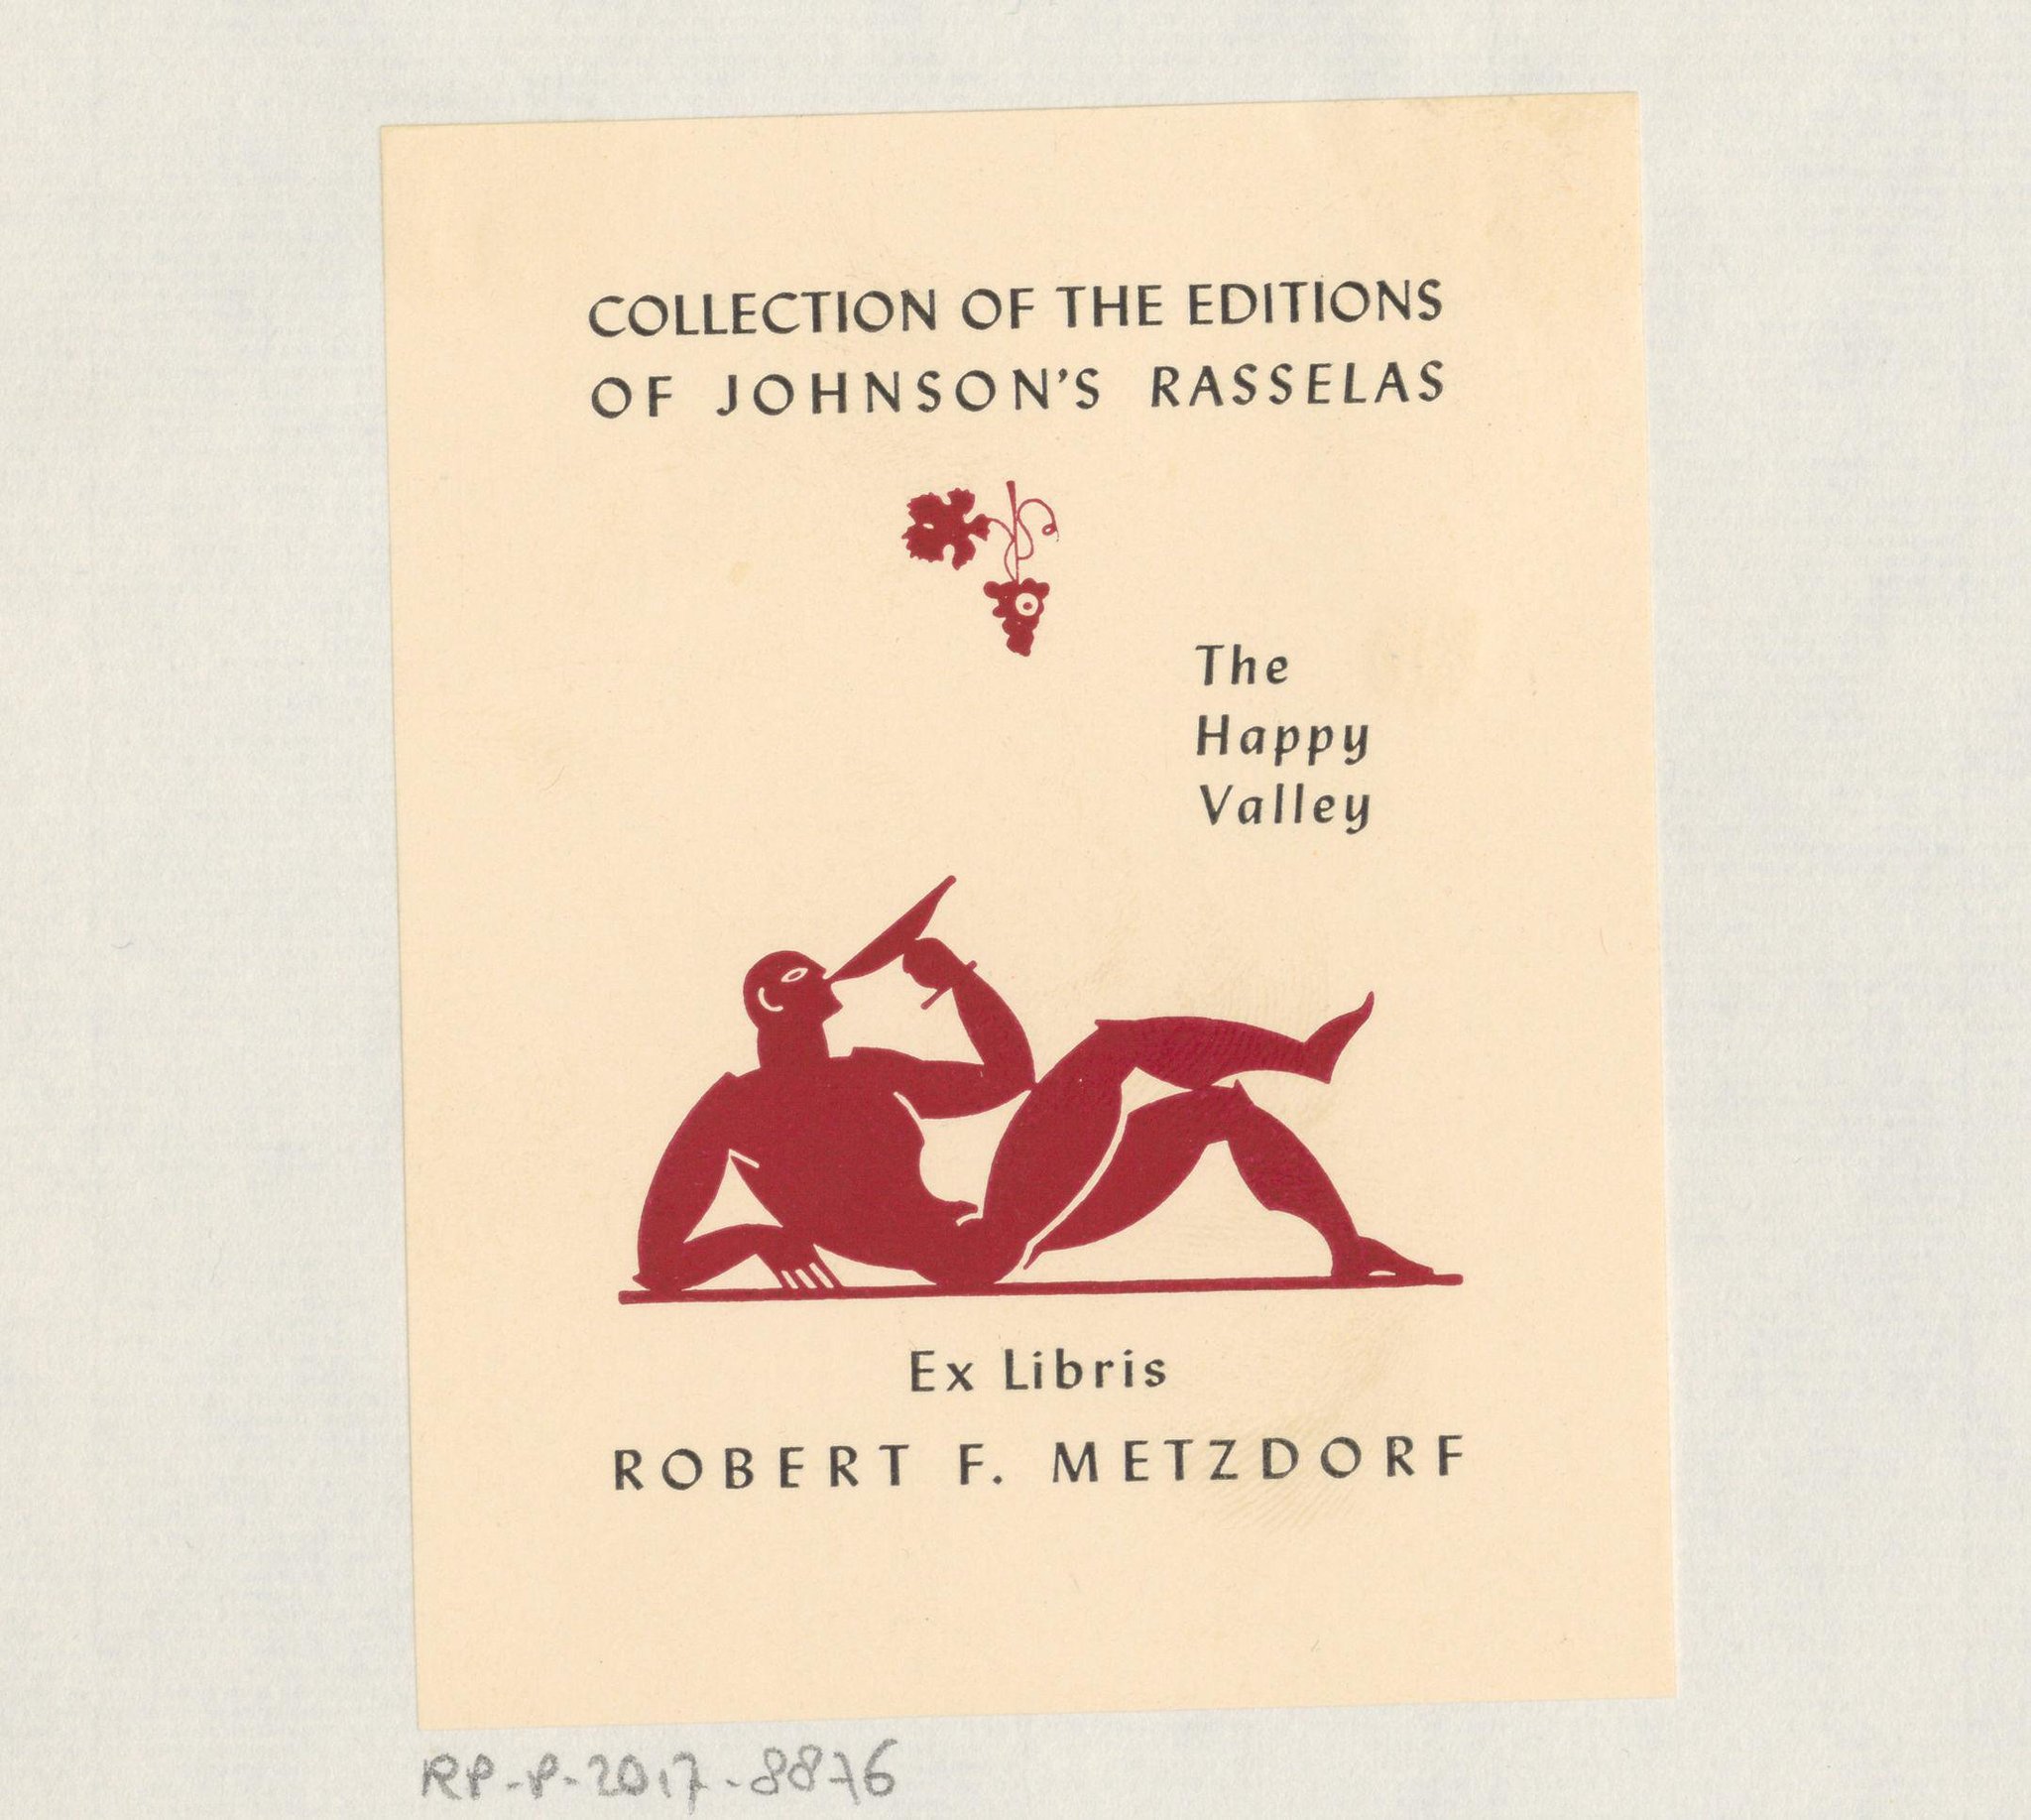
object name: bookplate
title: Collection of the editions of Jonson's Rasselas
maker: Anonymous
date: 1900-1999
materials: paper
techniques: printing block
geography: north and central america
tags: lying figure, bunch of grapes